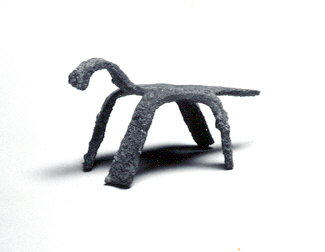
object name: figure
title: Zoomorphic Figure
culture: middle niger civilization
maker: middle niger artist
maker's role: artist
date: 801-1700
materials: copper alloy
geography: mali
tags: animals